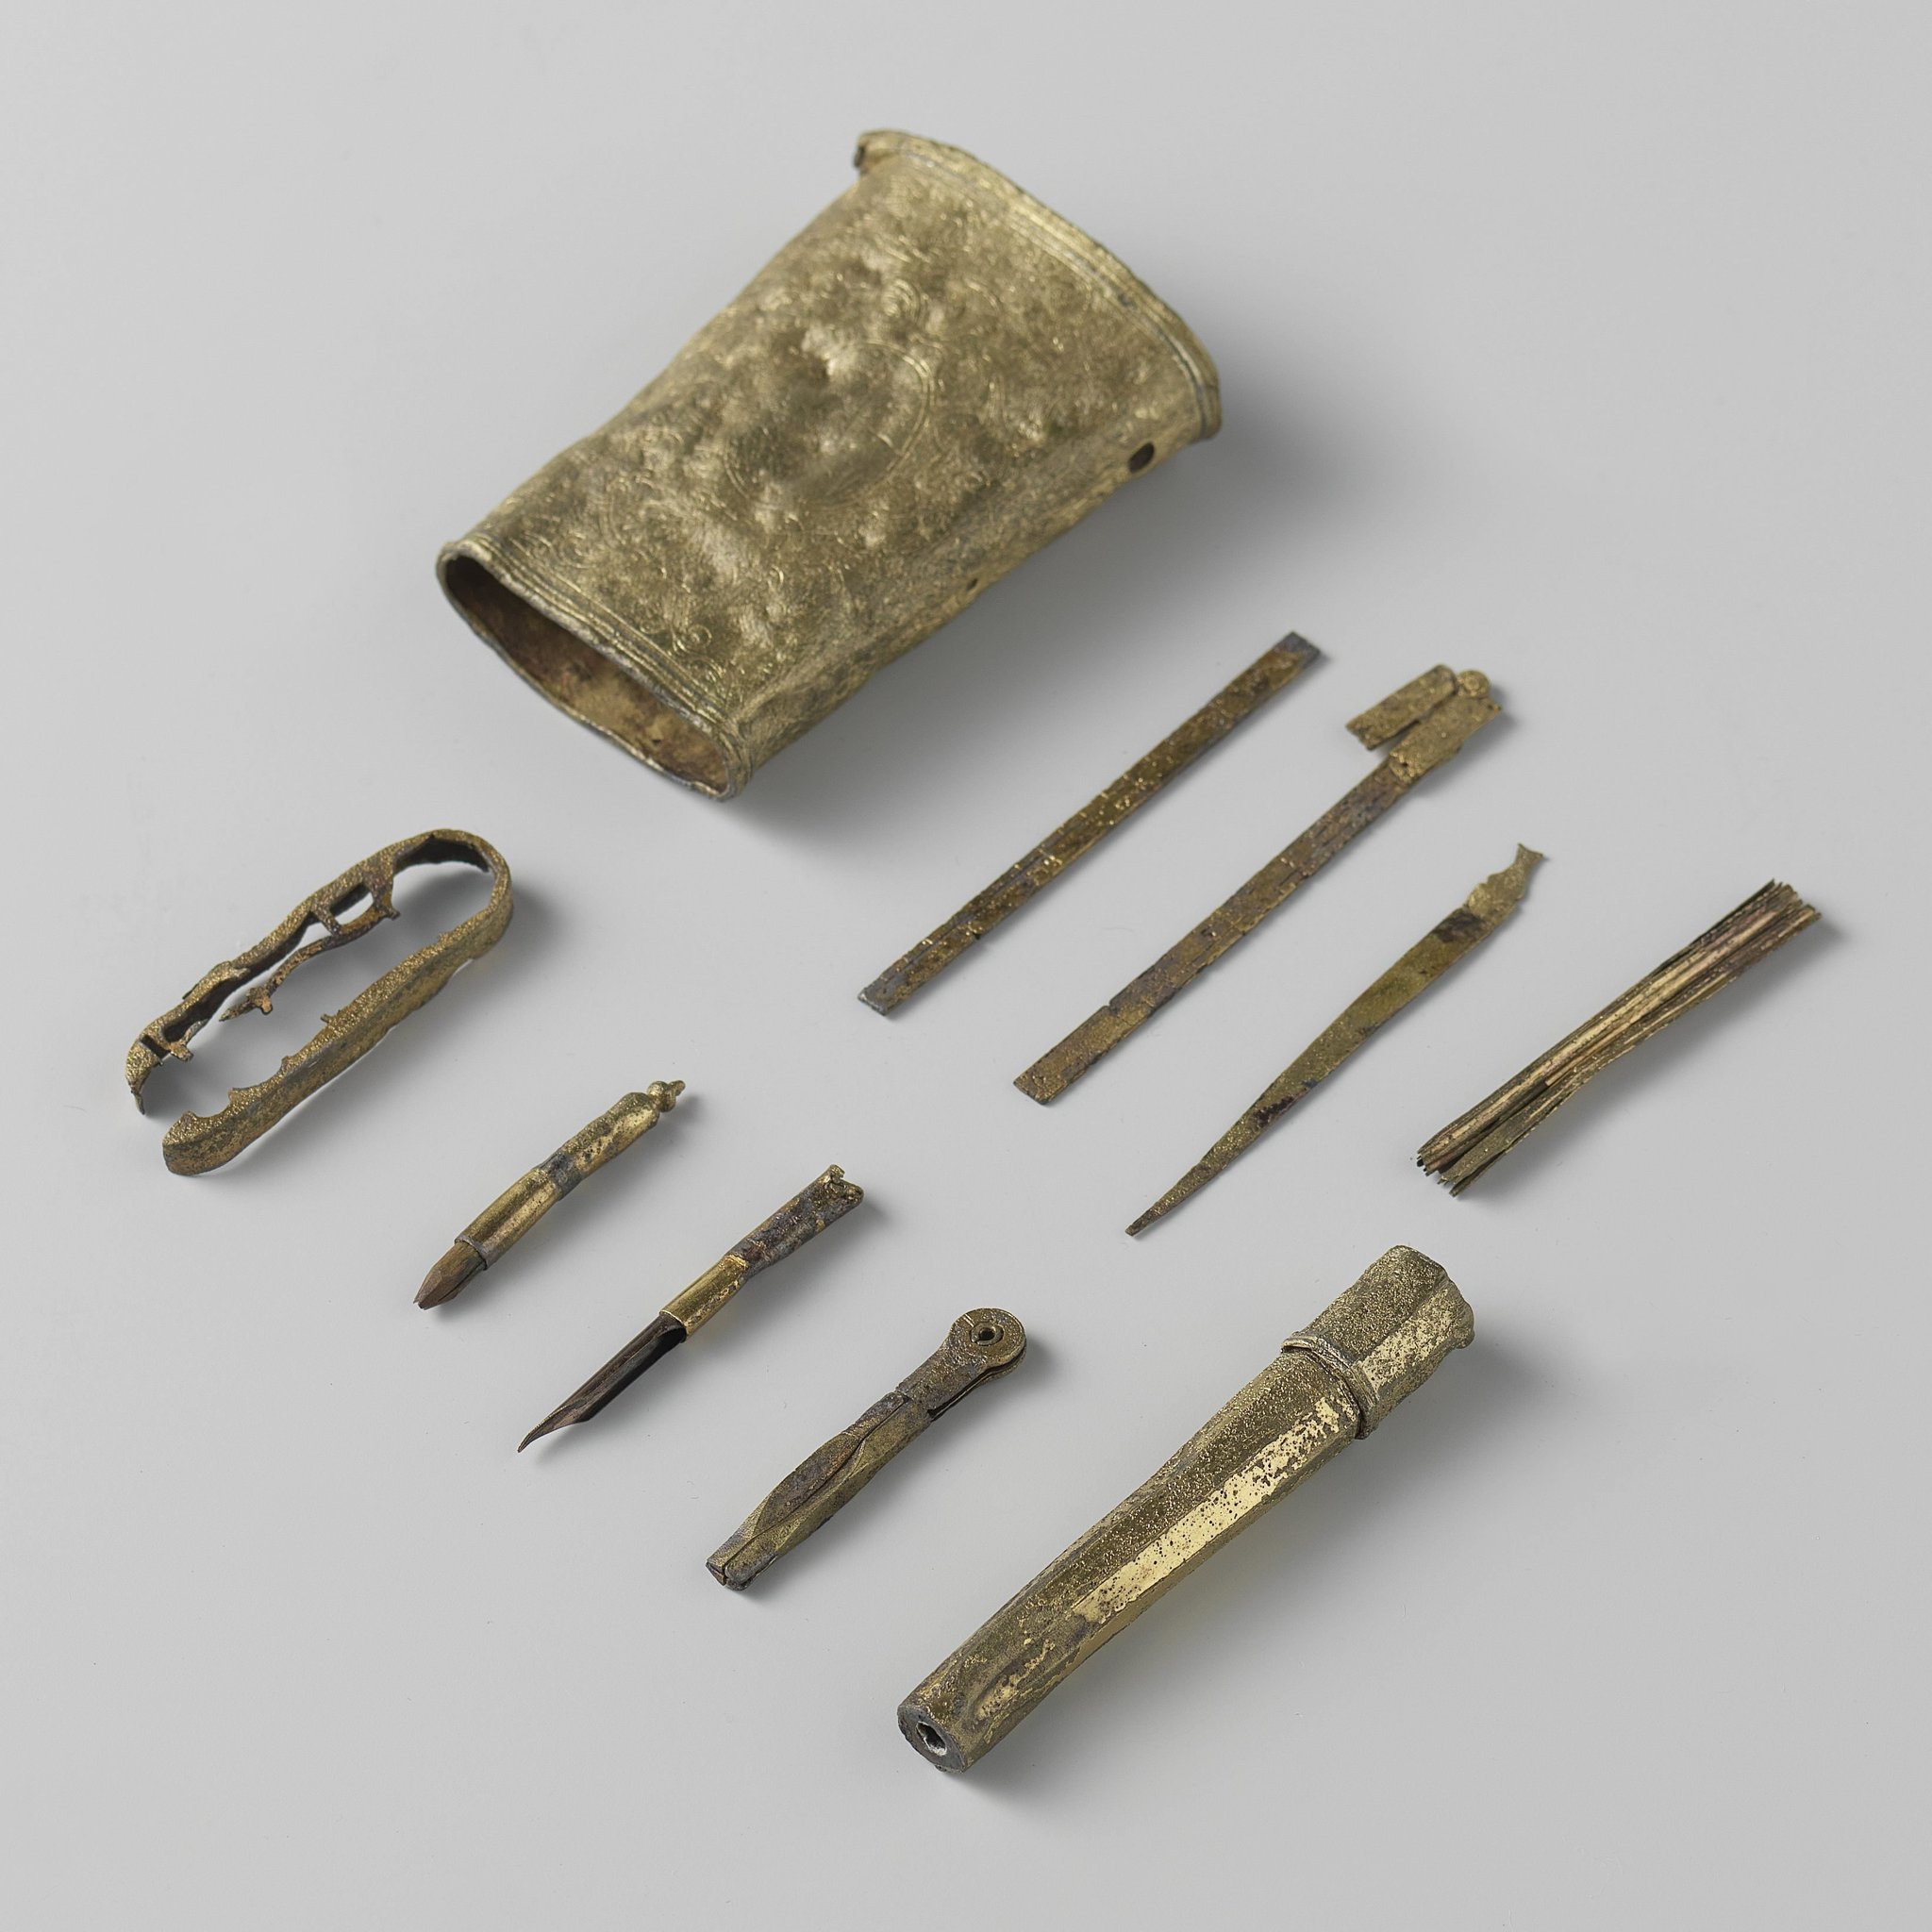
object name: pen holder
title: Nécessaire (case) with drawing implements from the wreck of the East Indiaman <Hollandia>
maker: Anonymous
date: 1700-1743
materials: copper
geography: netherlands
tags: verenigde oostindische compagnie, hollandia (schip), annet